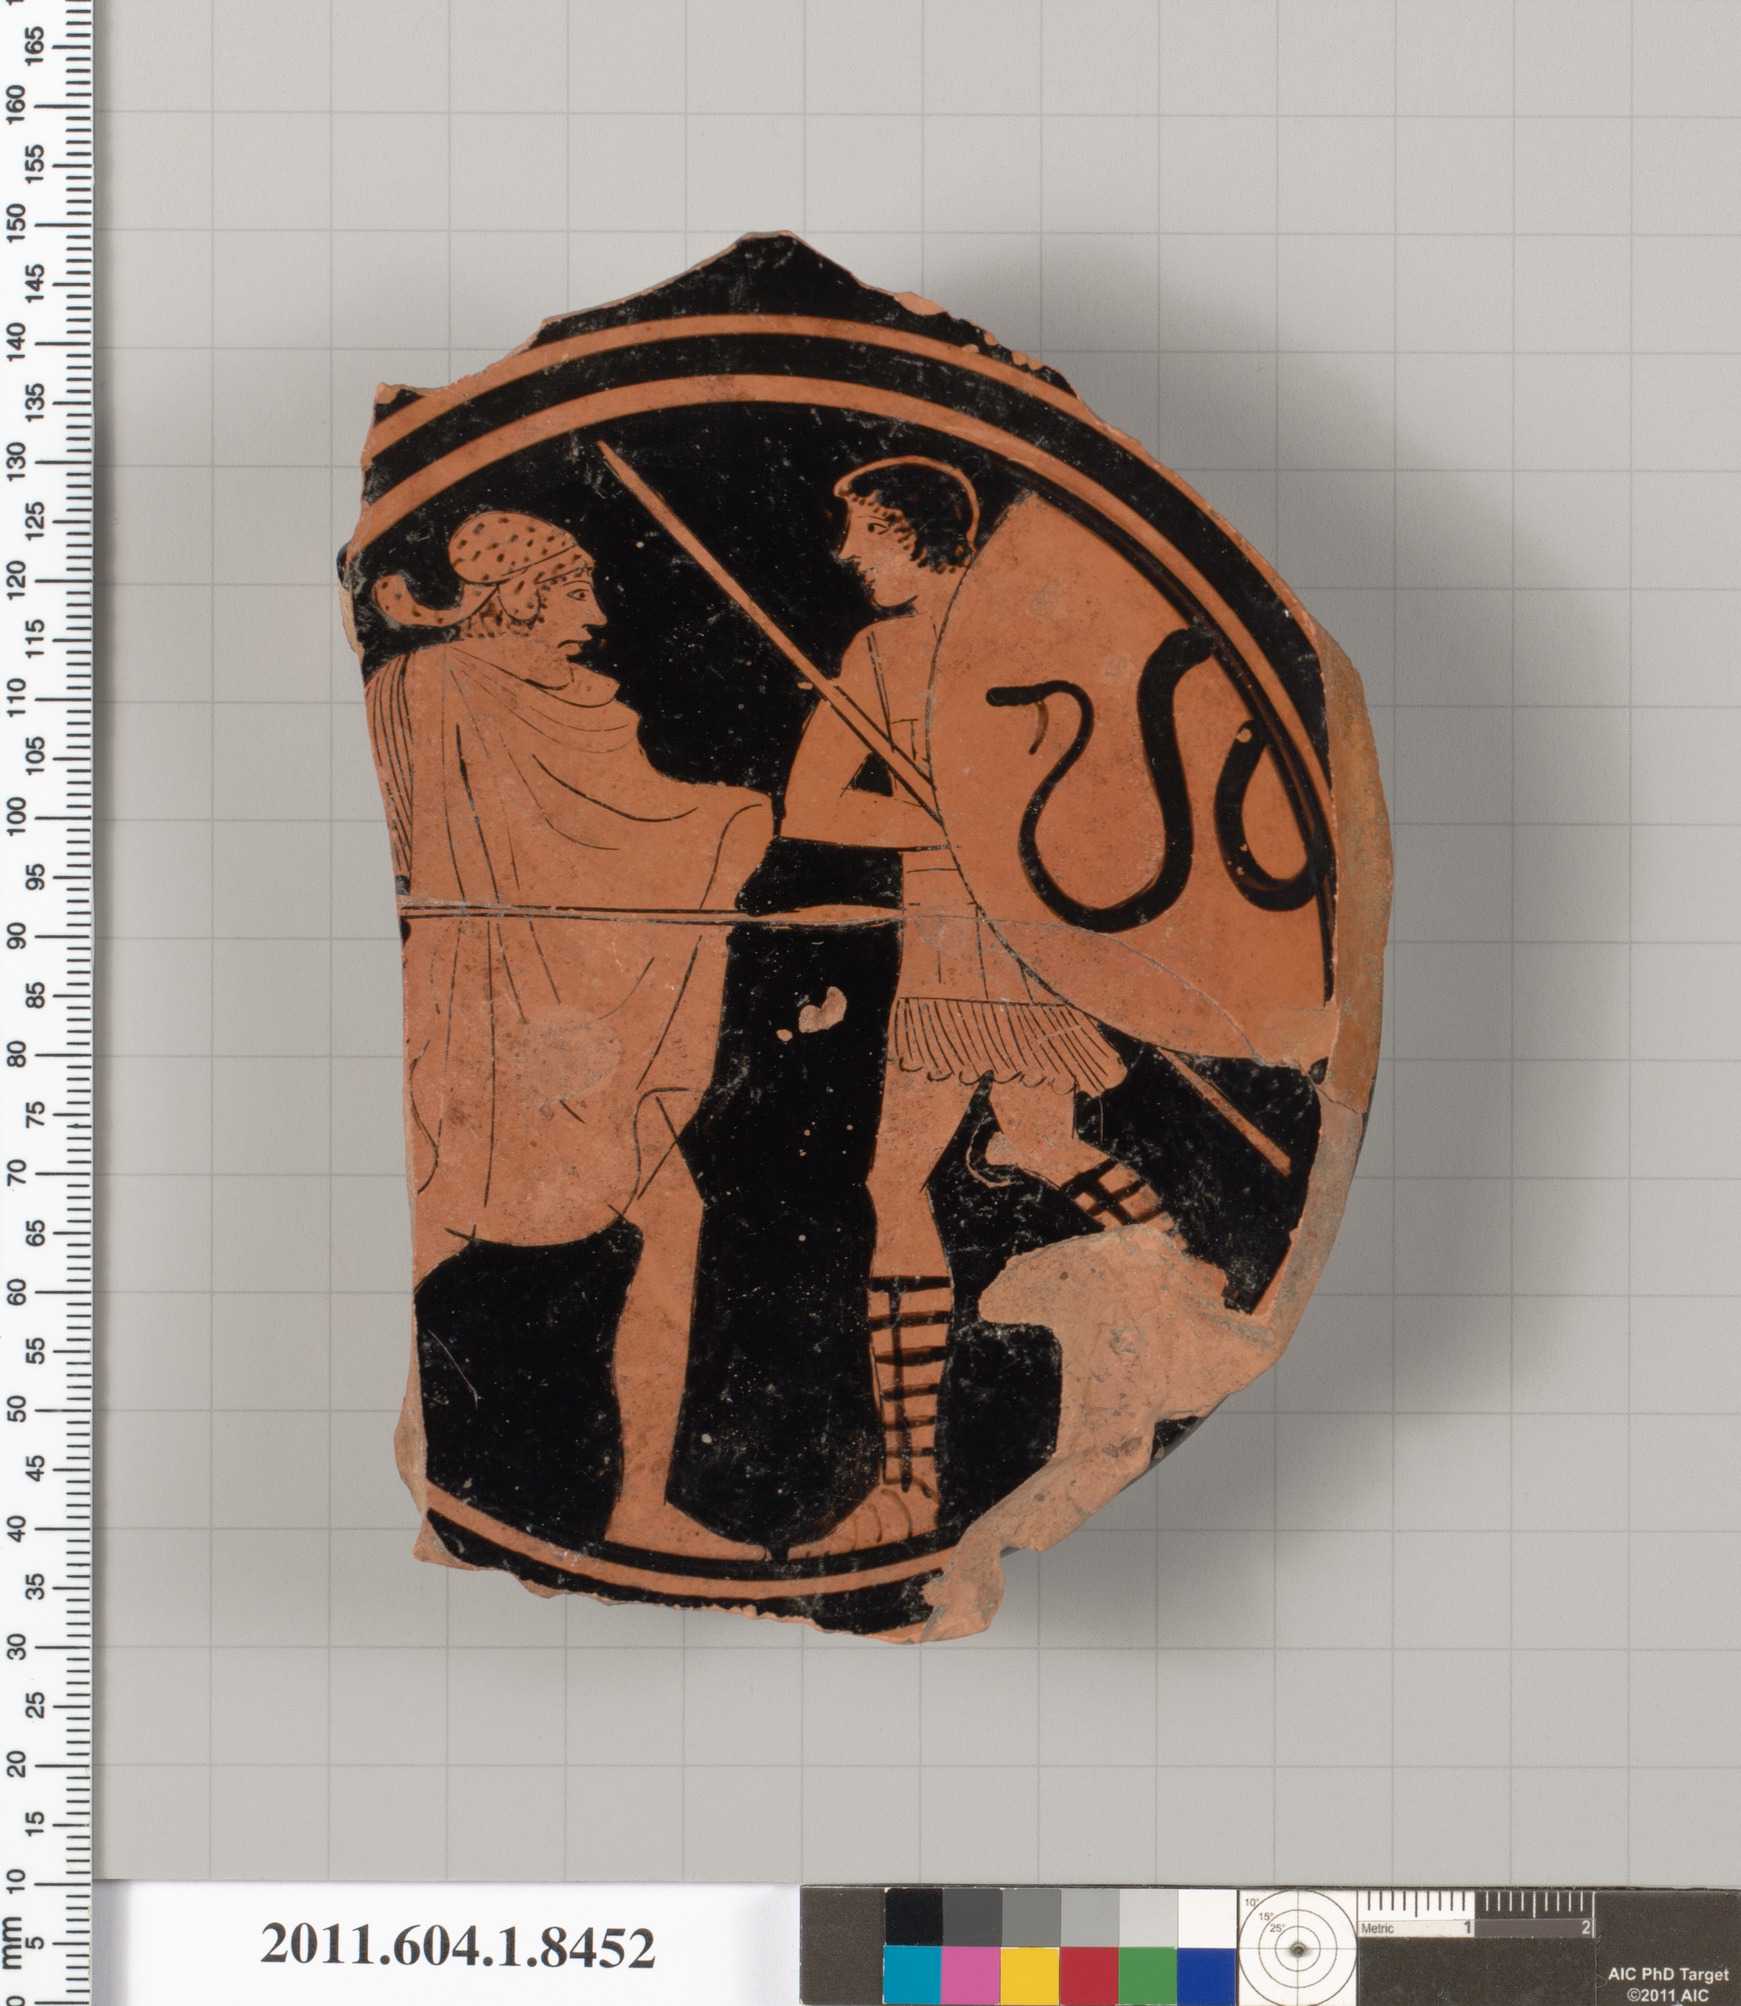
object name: kylix fragment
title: Terracotta fragment of a stemless kylix (drinking cup)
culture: greek, attic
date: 467-435 BCE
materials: terracotta